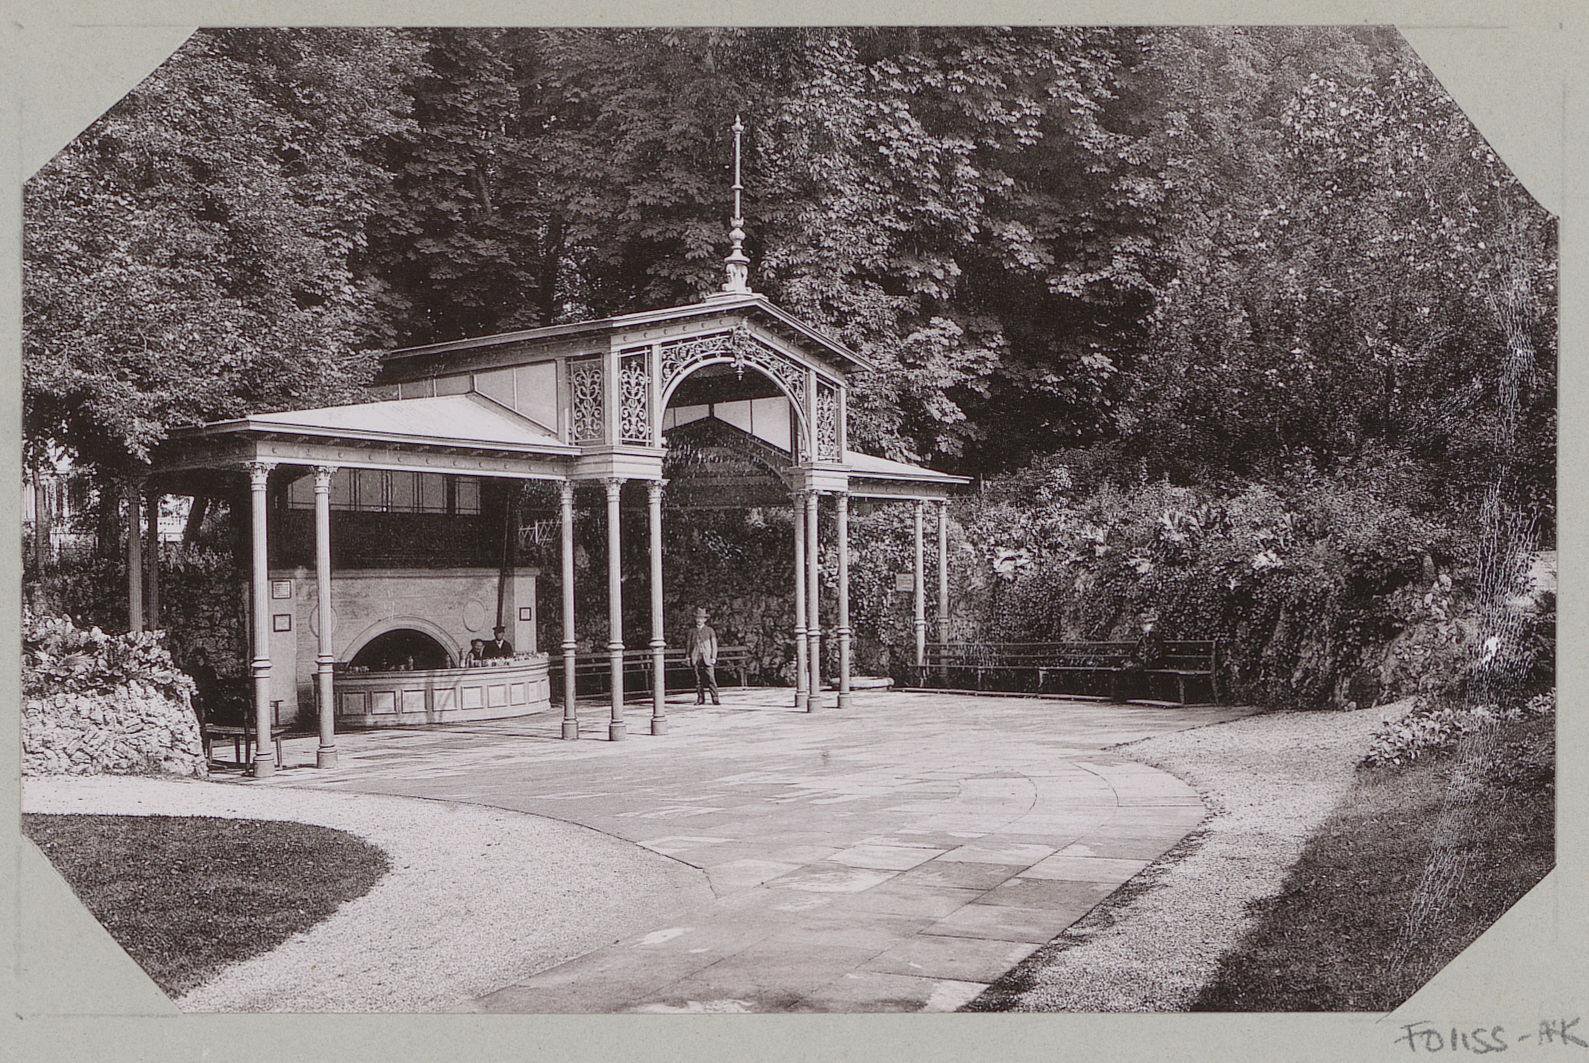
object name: photomechanical print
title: Gebouw van de Helenenquelle te Bad Pyrmont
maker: Anonymous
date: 1890-1897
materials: paper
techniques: photograph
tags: medicinal spring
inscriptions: annotation: ‘Helenenquelle’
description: Deze prent maakt deel uit van een album.